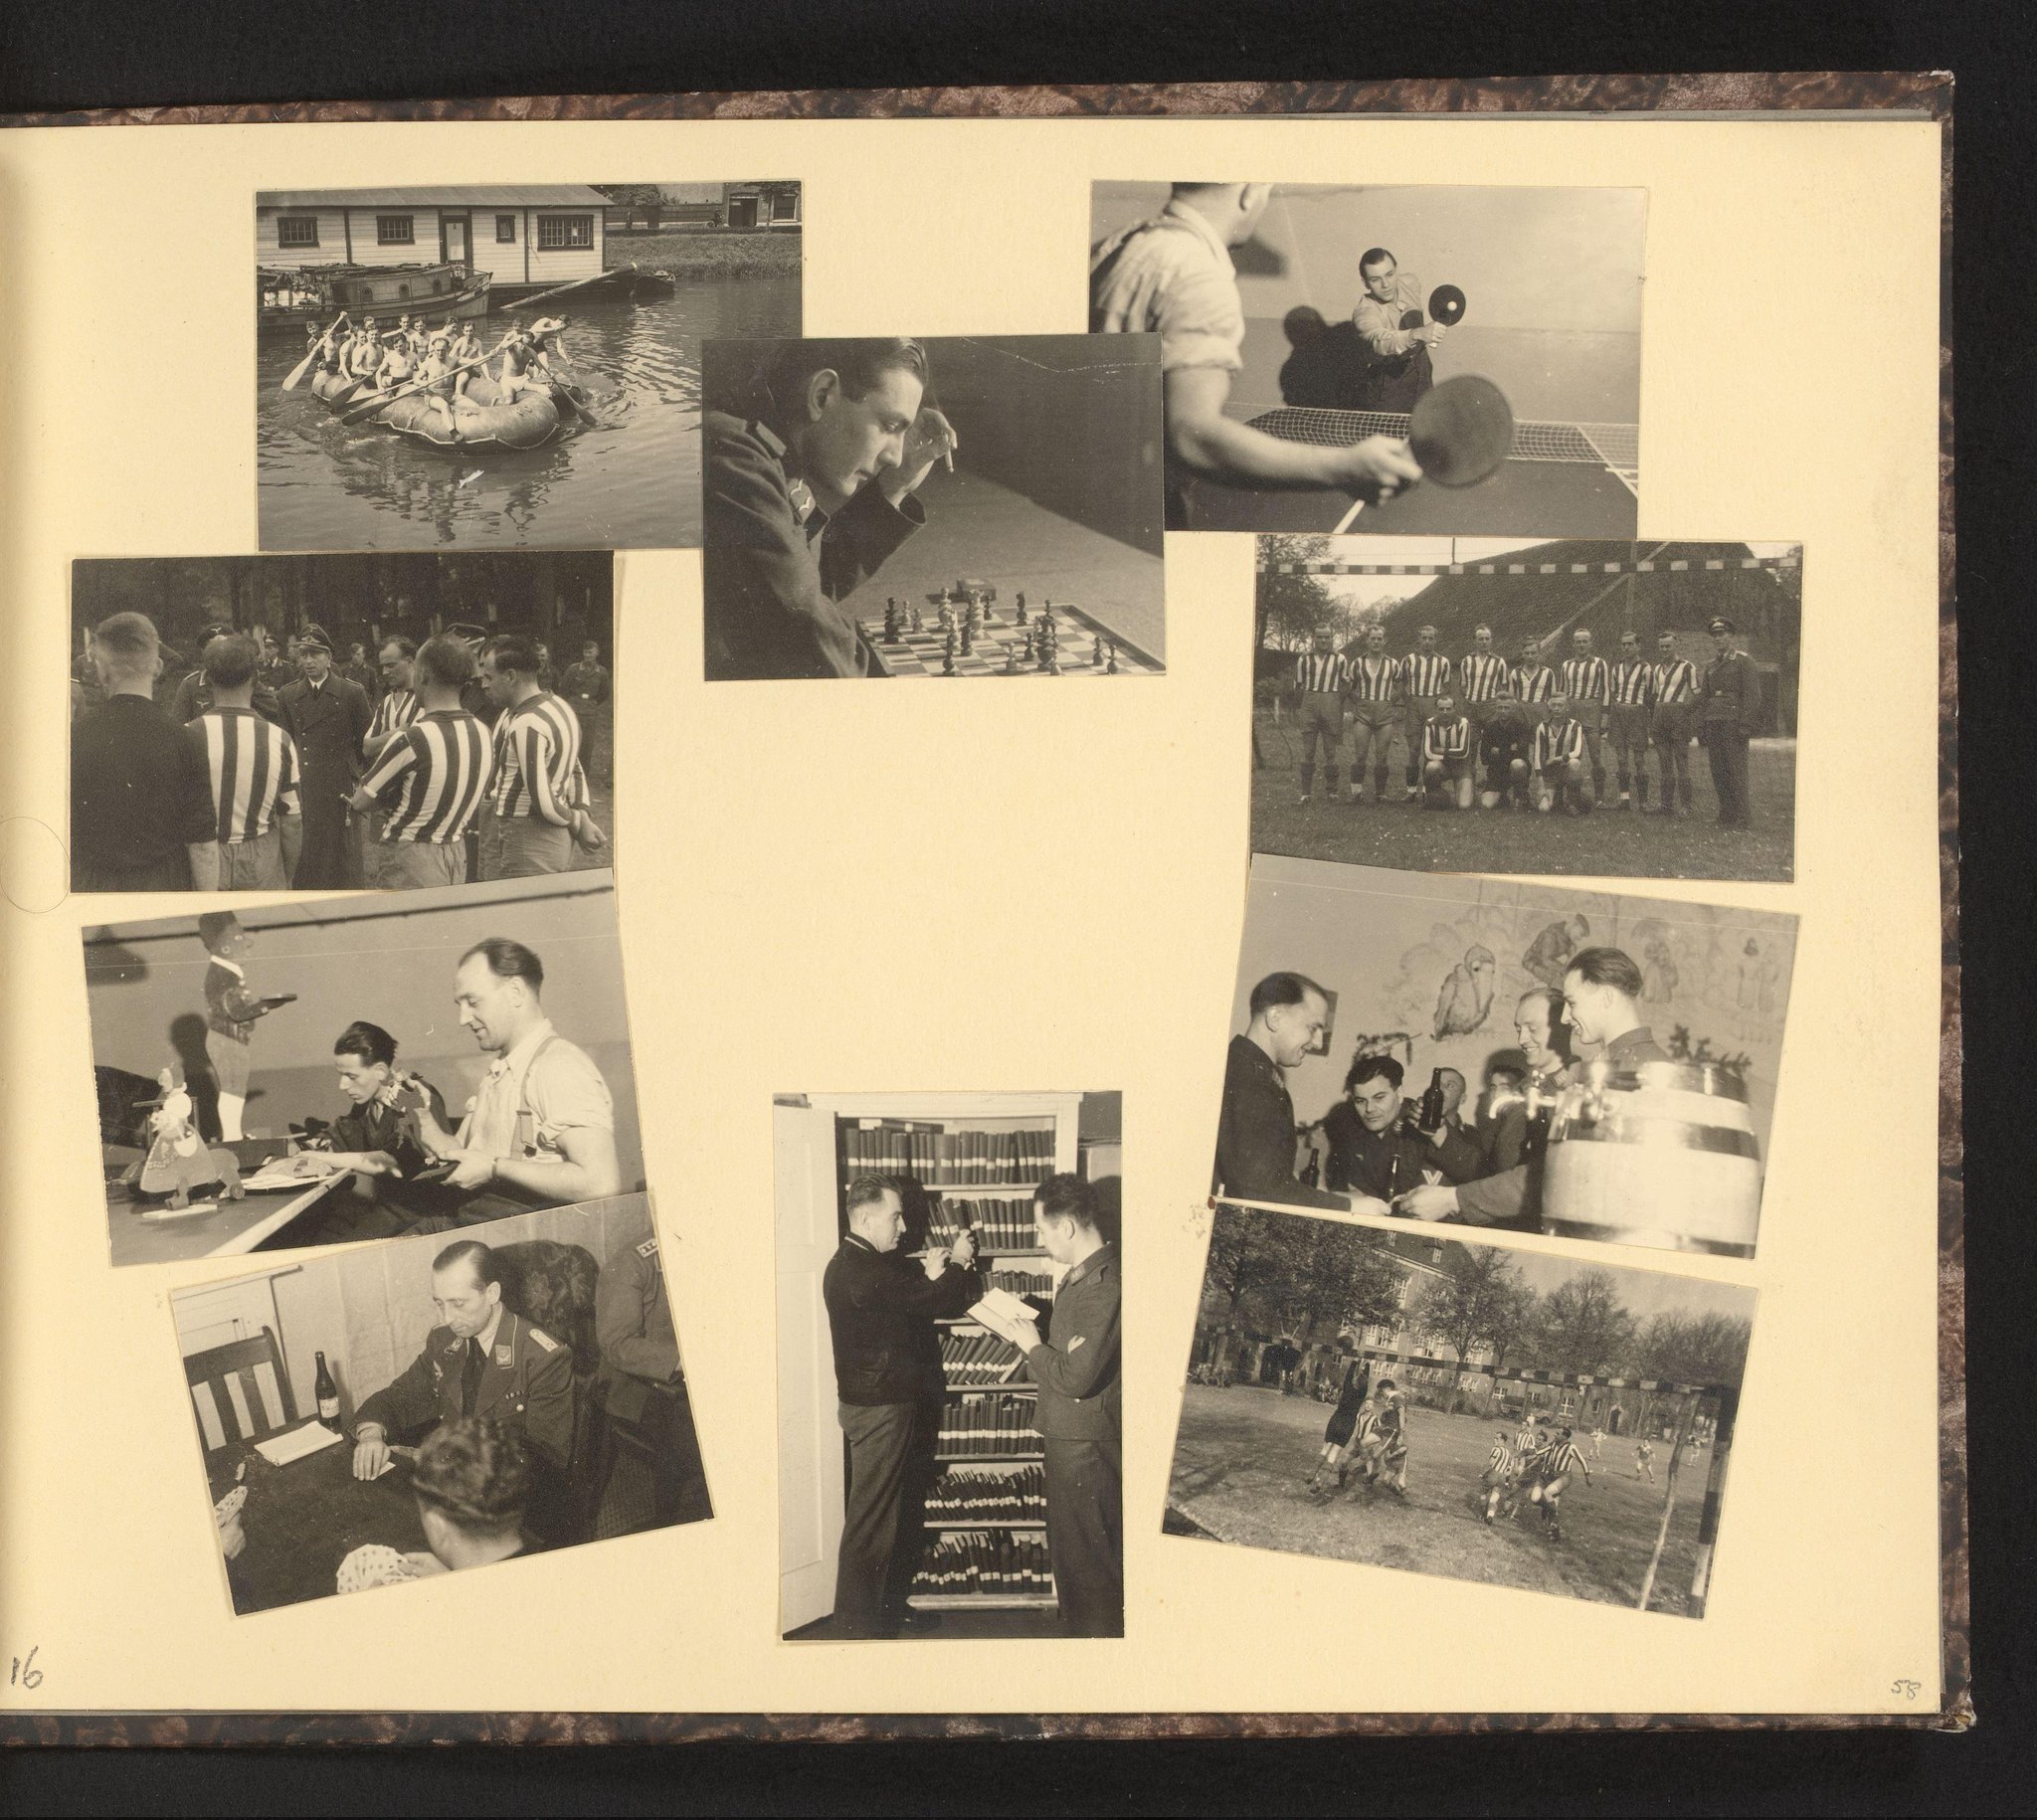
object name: photograph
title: Vrije tijd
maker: Anonymous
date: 1942-1943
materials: cardboard, photographic support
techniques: gelatin silver print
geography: breda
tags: the company, the unit, the troop ~ military service, recreation ~ the soldier off duty, sports, games and physical performances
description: Albumblad met een collage van tien foto's van de vrijetijdsbesteding van de militairen van de eenheid: roeien, schaken, voetbal, knutselen, tafeltennis en lezen. Onderdeel van het fotoalbum van de Luftnachrichten-Regiment 211,1942-1943.